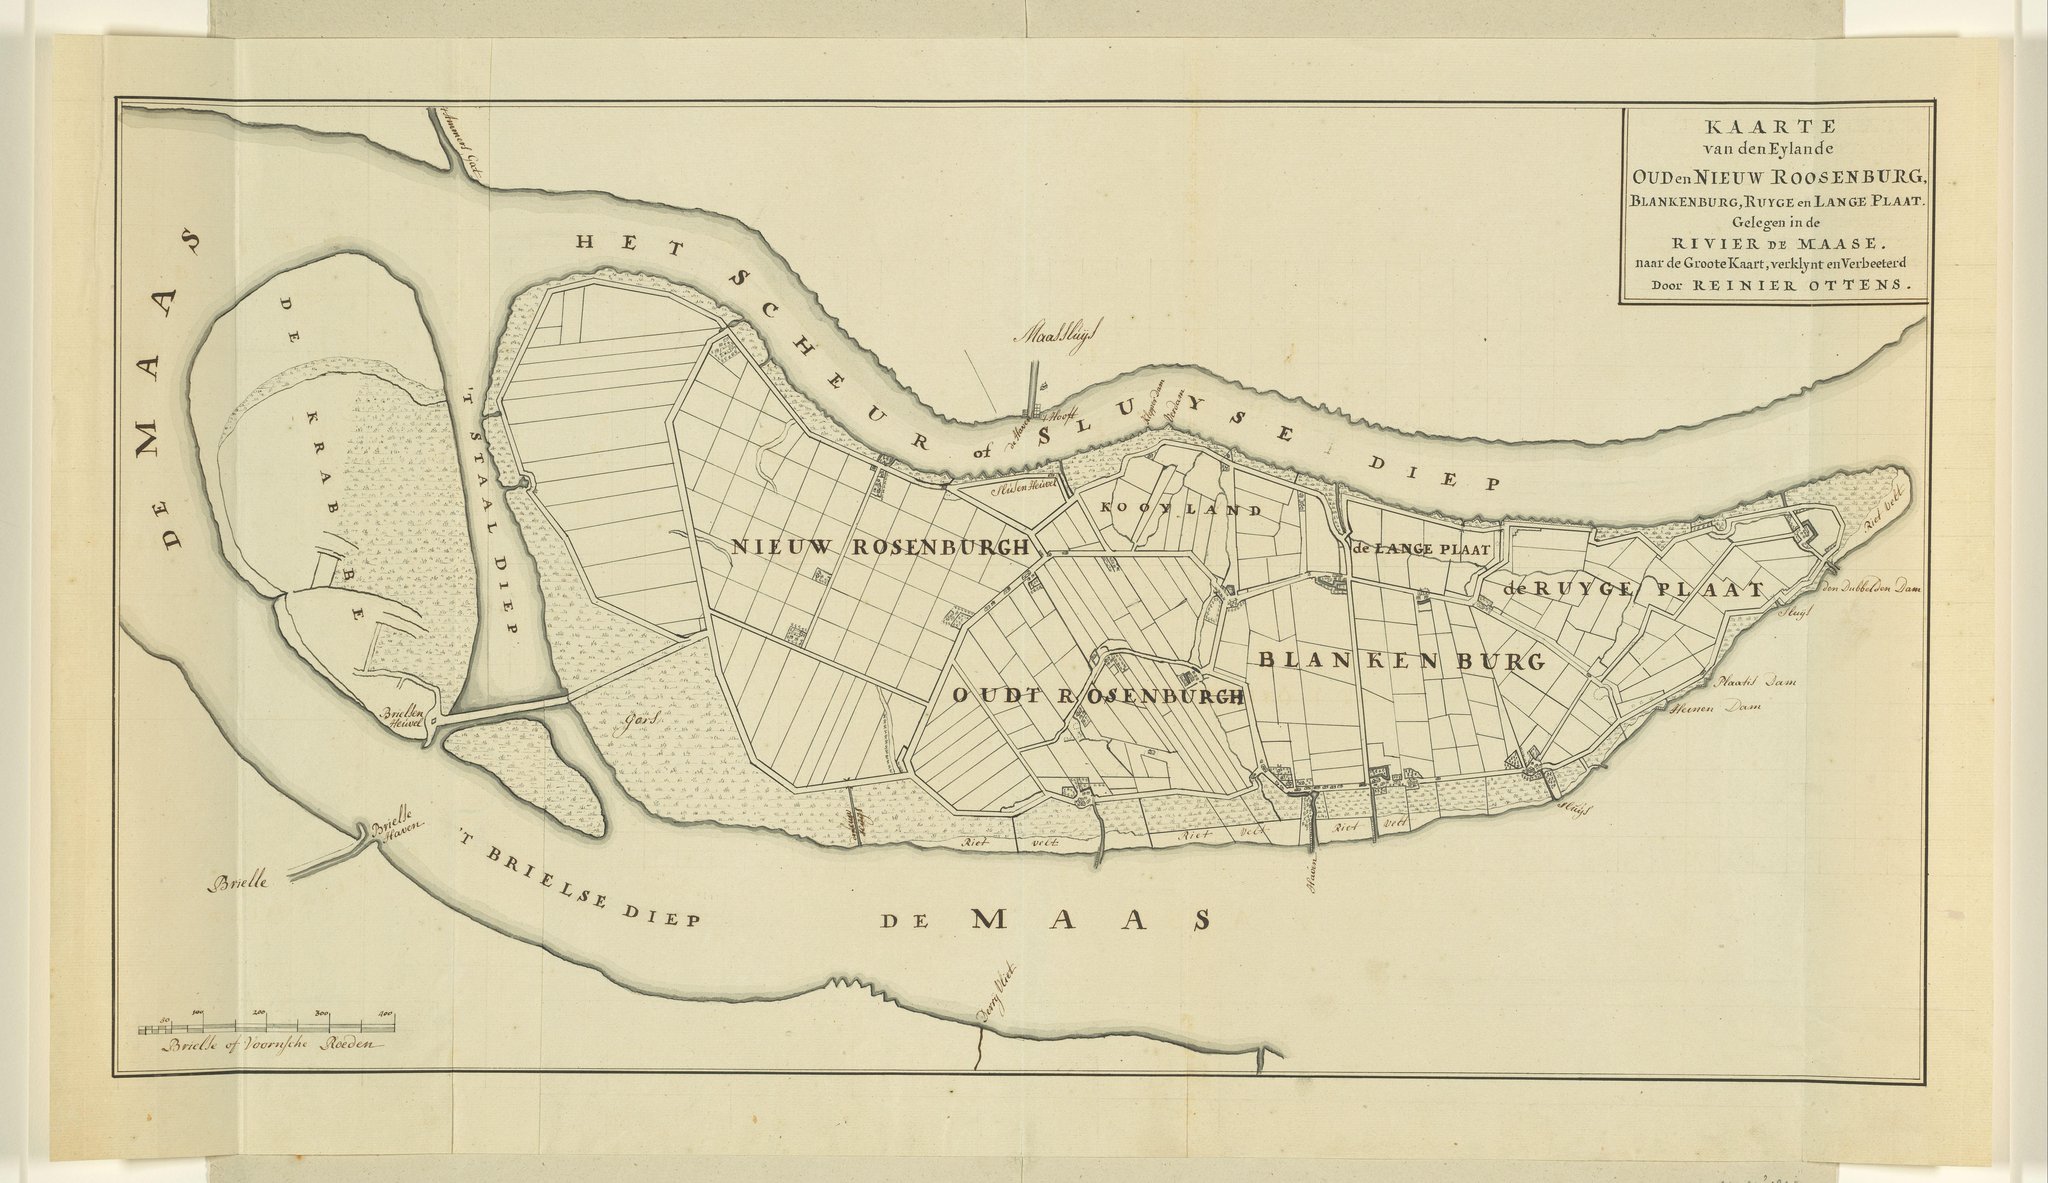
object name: drawing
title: Kaarte van den eylande Oud en Nieuw Roosenburg, Blankenburg, Ruyge en Lange Plaat. Gelegen in de rivier de Maase. Naar de groote kaart, verklynt en verbeeterd door Reinier Ottens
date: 1727-1772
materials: ink, paper, pencil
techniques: brush, pen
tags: maps of separate countries or regions, polder, reclaimed land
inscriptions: collector's mark: Lugt 2228, collector's mark: Lugt 195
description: Kaart van het eiland Rozenburg, gelegen in de Maas. In verkleinde en verbeterde vorm getekend naar de achtdelige kaart 'Kaarte ende meetinge … van den eijlande Oudt en Nieuw Roosenburg…' (RP-P-AO-13-8). Linksonder een schaalstok: 400 Brielle of Voornsche roeden. Rechtsboven de titelcartouche. Met rooster.